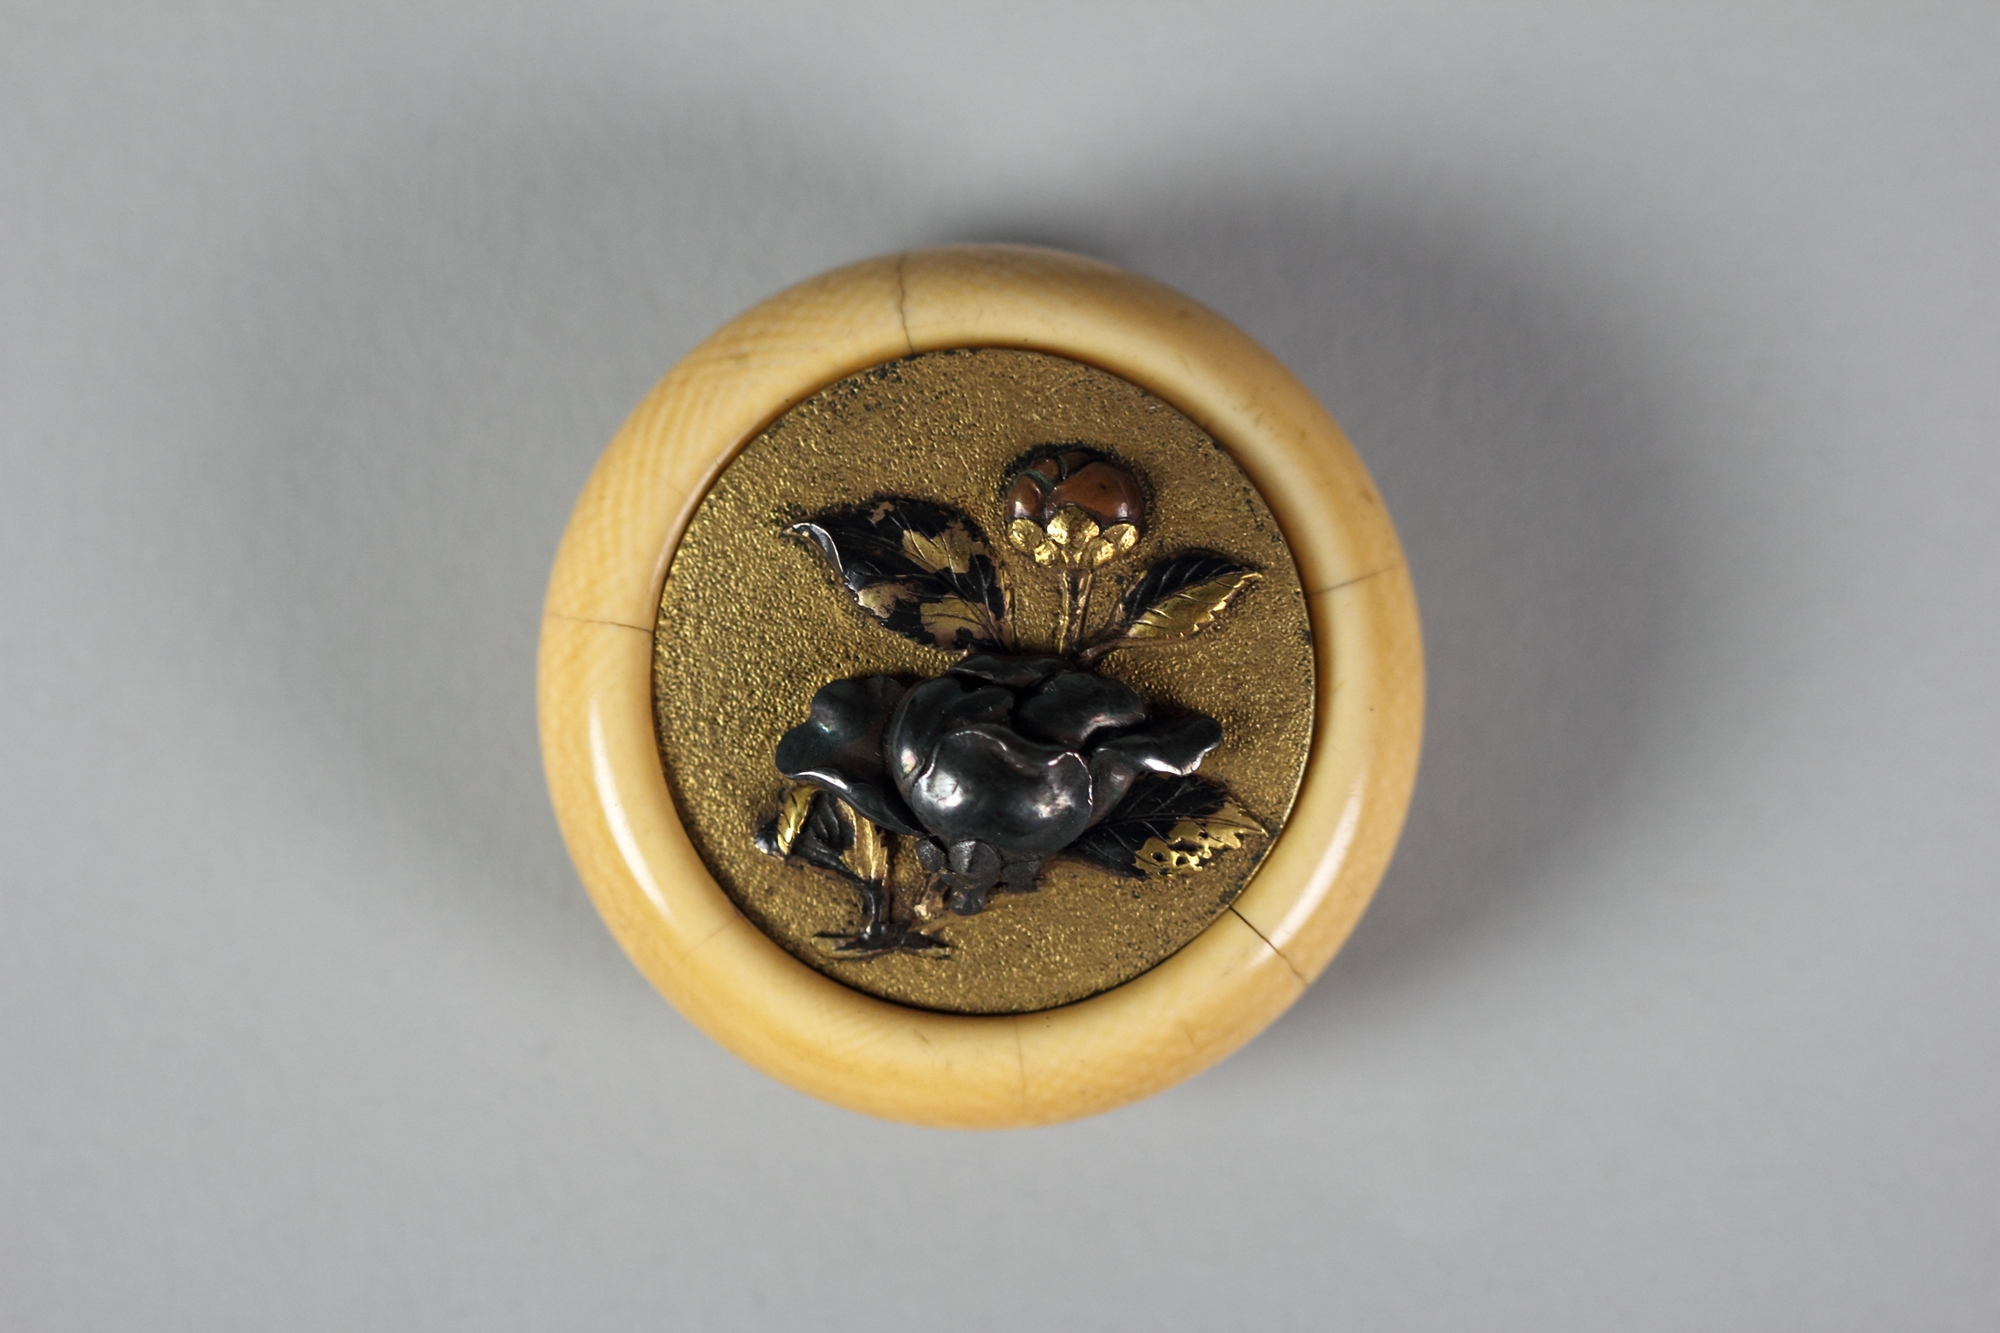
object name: netsuke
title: Netsuke of Peony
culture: japanese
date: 1801-1900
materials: ivory, metal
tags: peonies